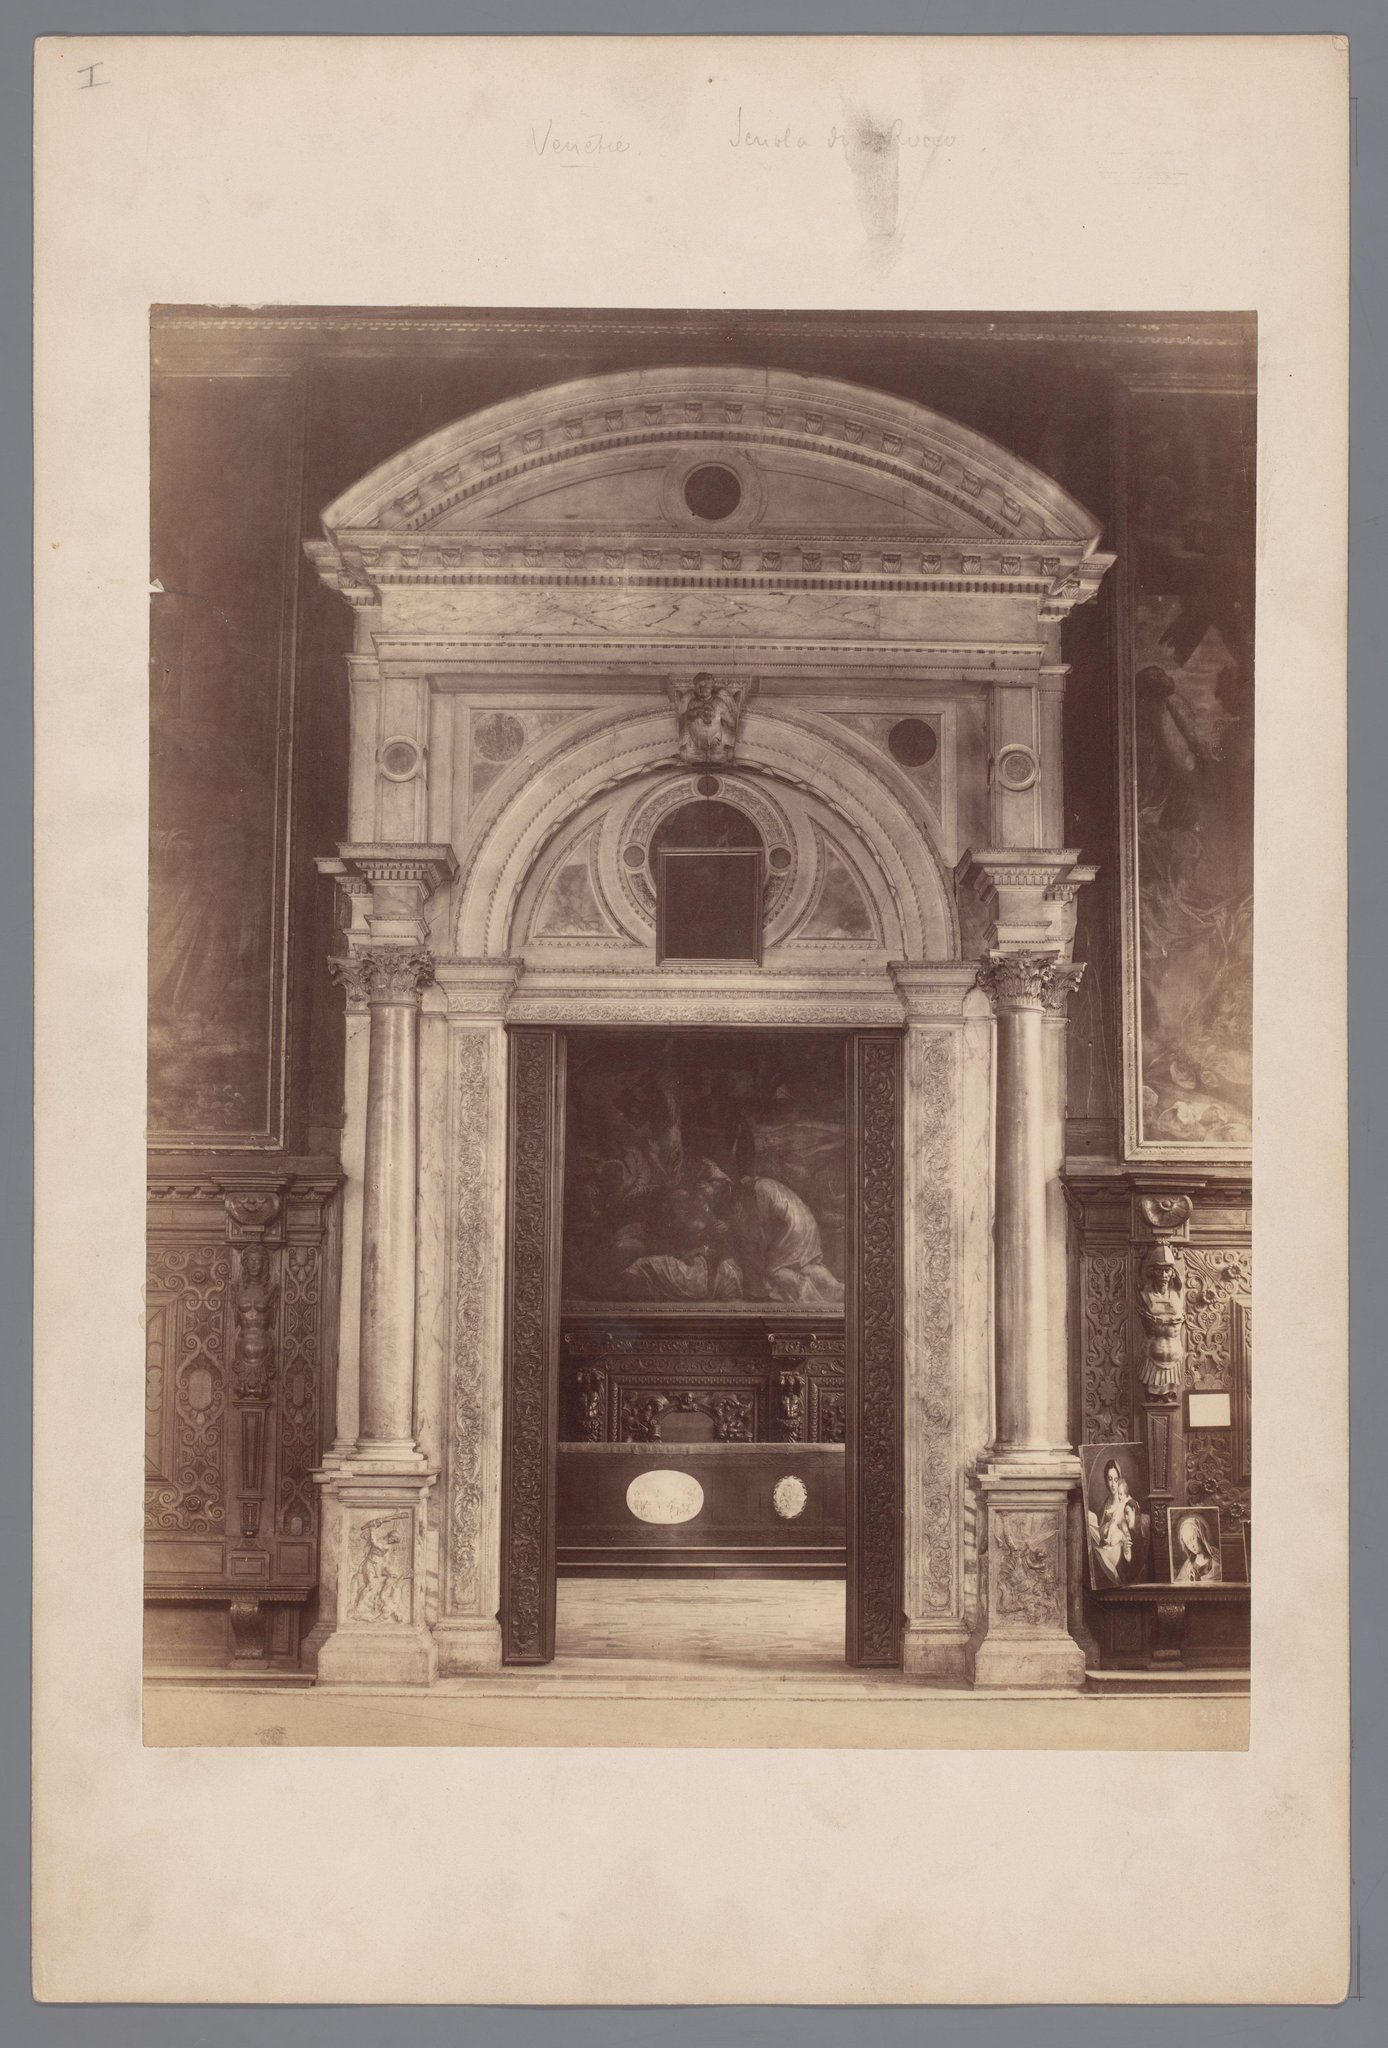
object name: photograph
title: Interieur van de Scuola Grande di San Rocco te Venetië, Italië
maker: Anonymous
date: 1851-1900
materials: cardboard, paper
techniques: albumen print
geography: venice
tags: column, pillar ~ architecture, interior ~ representation of a building, wall-covering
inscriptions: inscription: ‘pl 10 Italie.. [...]’, inscription: ‘I’